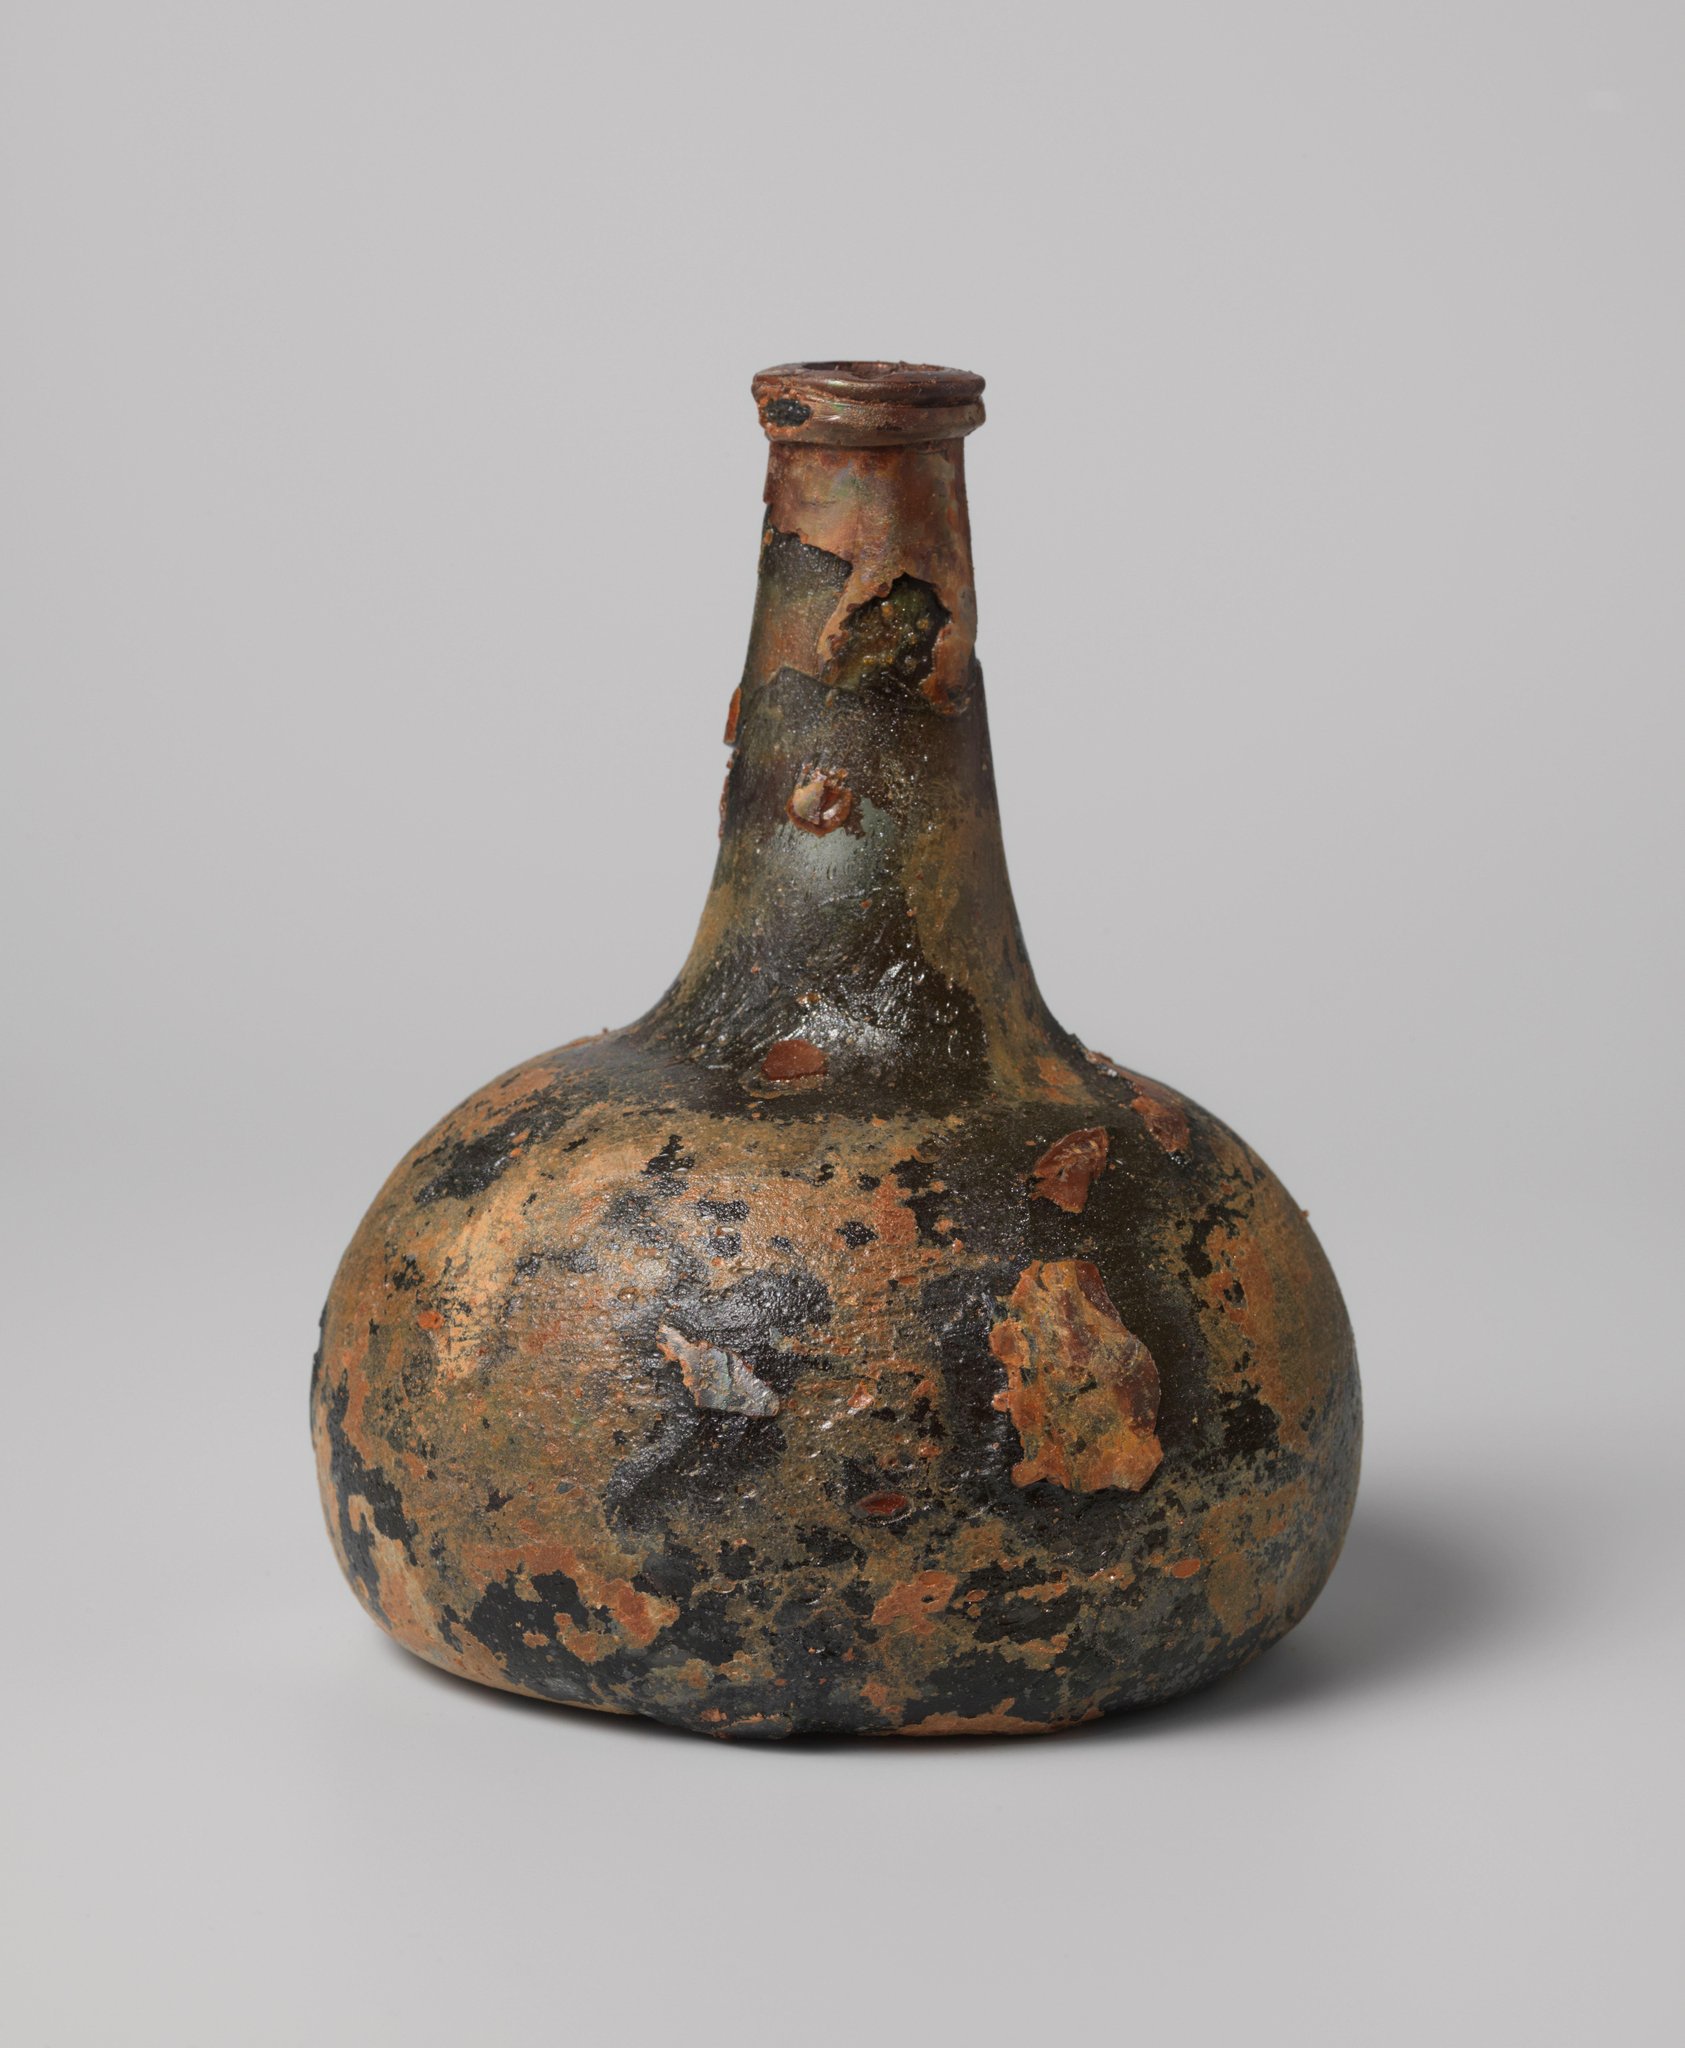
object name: wine bottle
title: Wijnfles uit het wrak van de Oost-Indiëvaarder Hollandia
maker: Anonymous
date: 1700-1743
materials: glass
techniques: green glass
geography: netherlands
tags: verenigde oostindische compagnie, hollandia (schip), annet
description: Wine bottle, continental production, onion-shaped, complete; (1) eroded (17h, belly 14.5d, base 11d), vs-string rim, cs-kick-up.